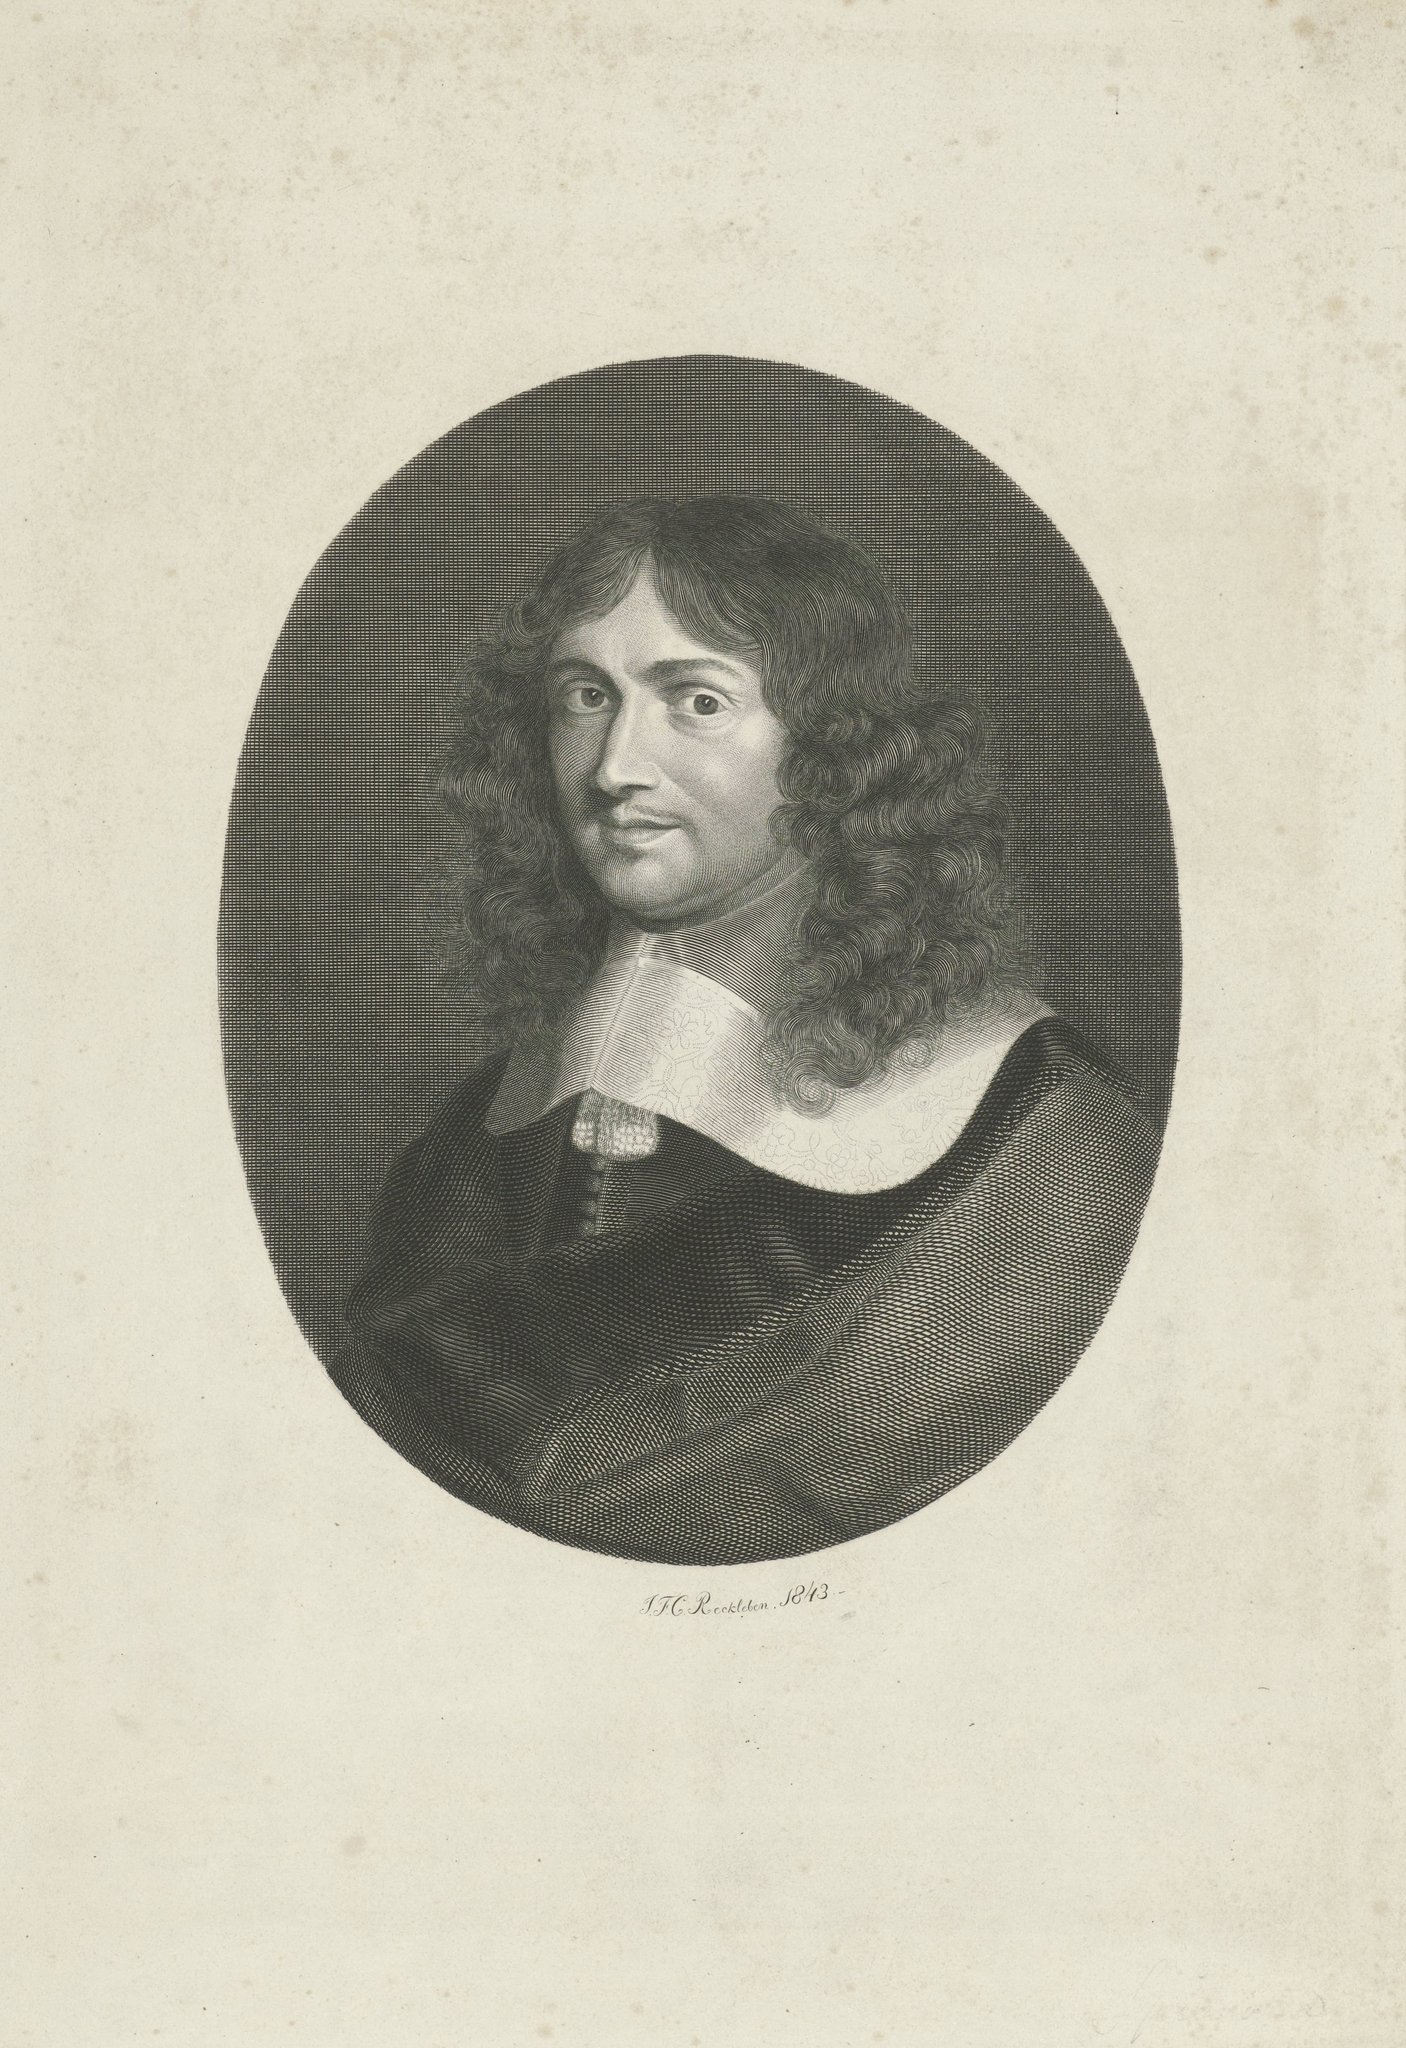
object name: print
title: Portret van Jean-Baptiste Colbert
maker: jan frederik christiaan reckleben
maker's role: print maker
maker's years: 1819-1879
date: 1843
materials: paper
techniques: engraving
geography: amsterdam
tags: paris, politician, jean-baptiste colbert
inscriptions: collector's mark: Lugt 2228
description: Portret van Jean-Baptiste Colbert, markies van Seignelay en Frans politicus.